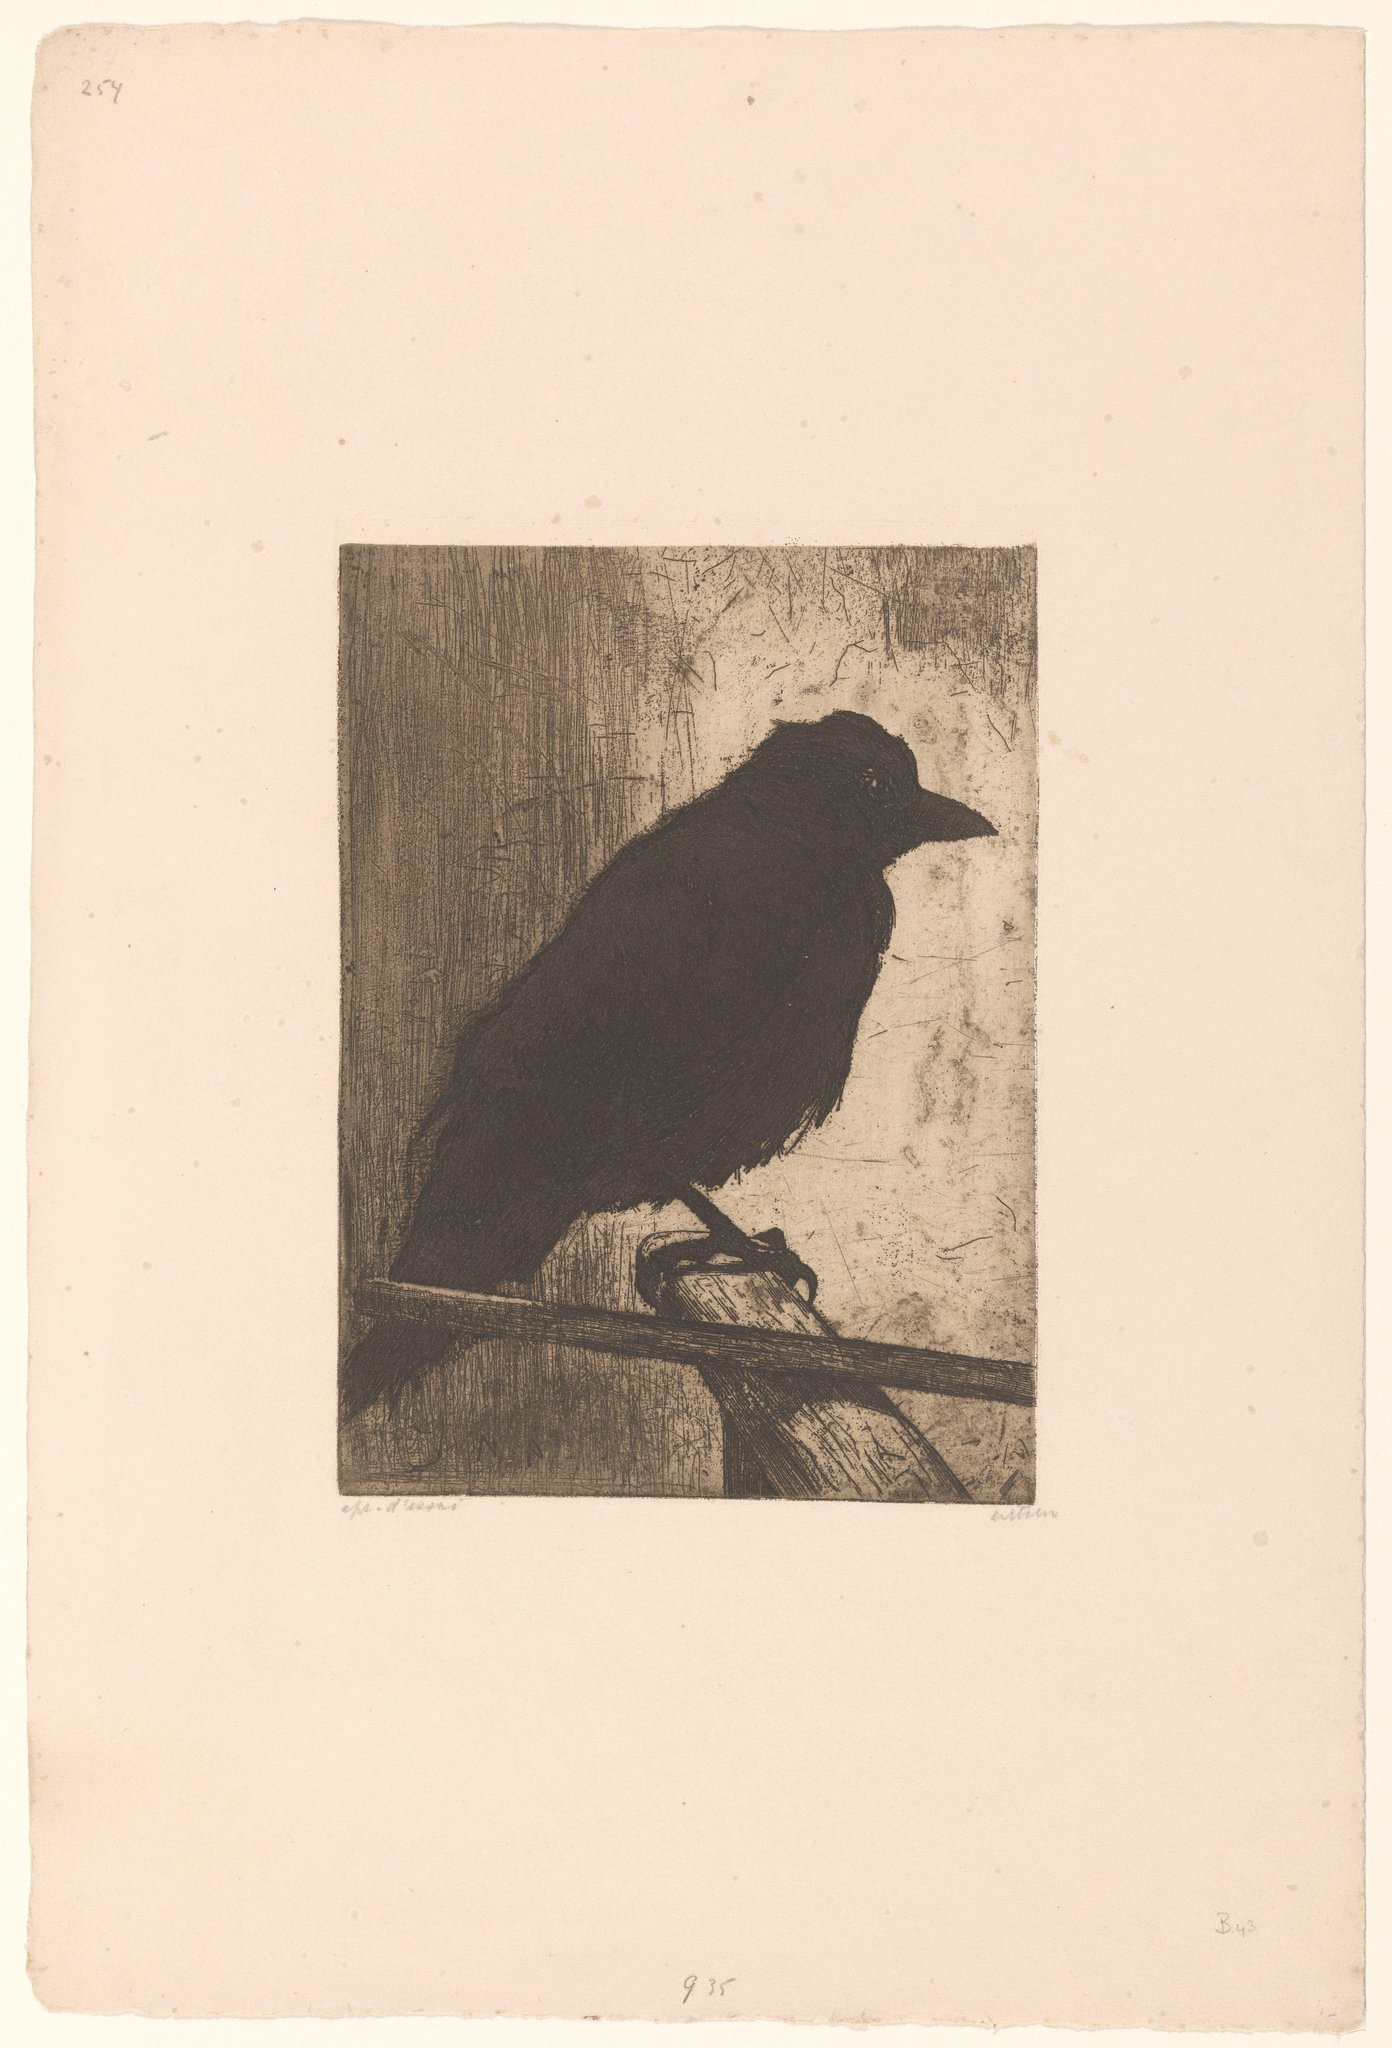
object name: print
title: Ina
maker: willem witsen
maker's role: draughtsman, painter, print maker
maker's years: 1860-1923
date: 1887-1888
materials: paper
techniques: etching, intaglio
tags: song-birds: crow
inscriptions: inscription: ‘epr. d'essai’, watermark:, signature: ‘Witsen’, collector's mark: Lugt 2228